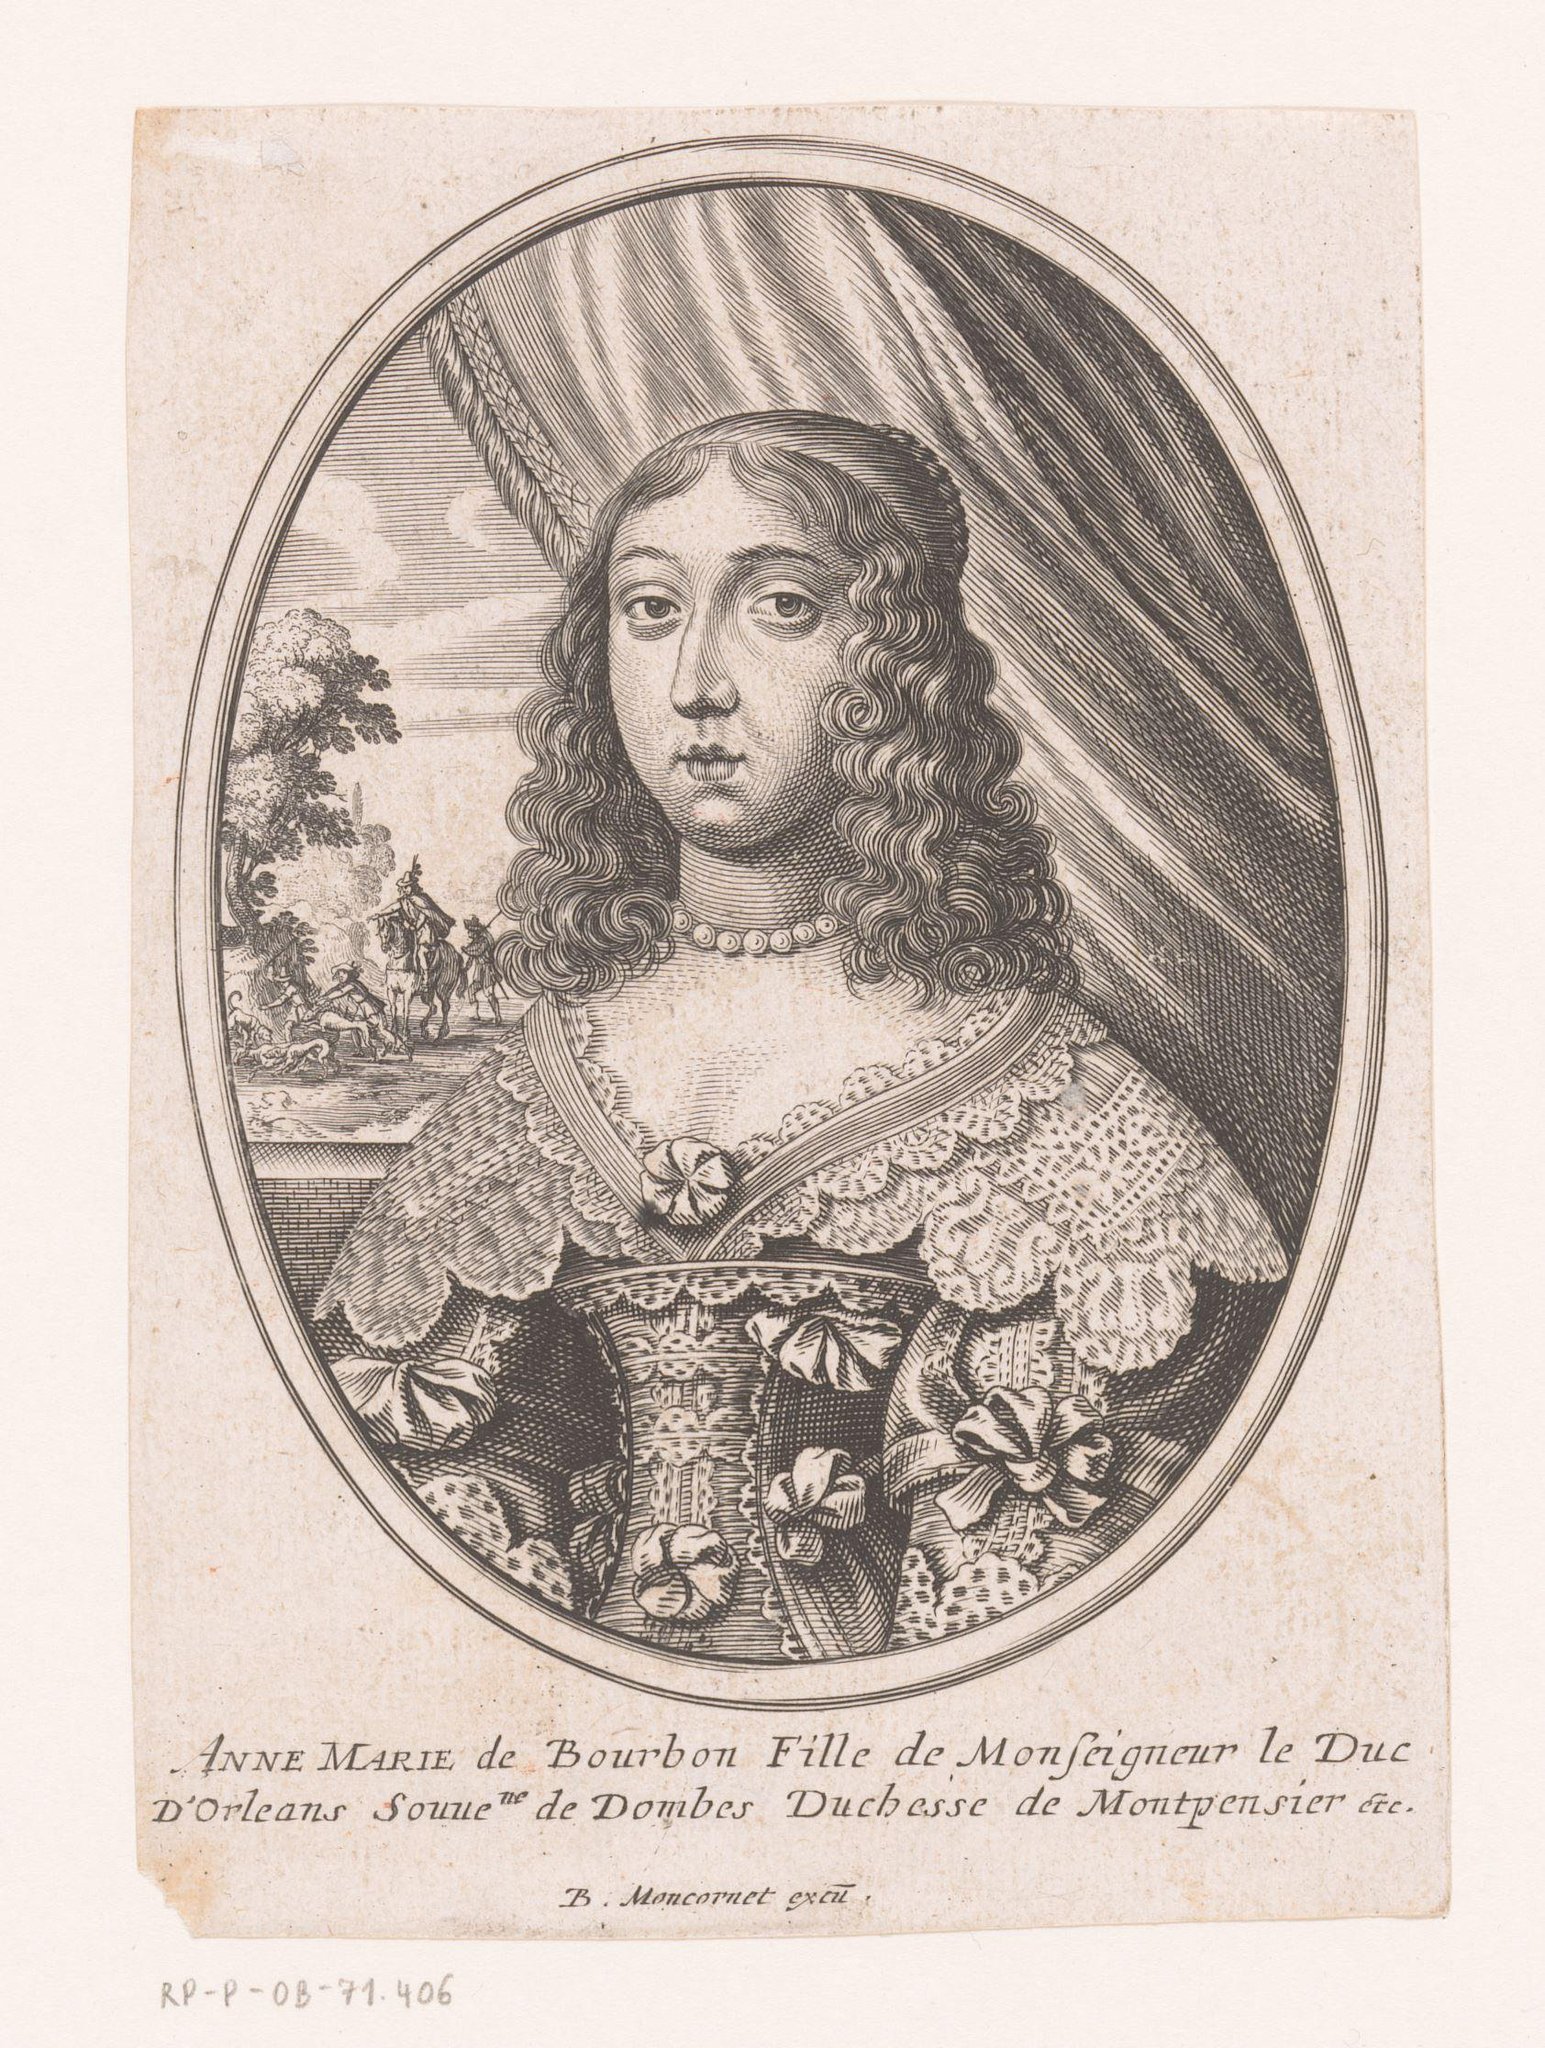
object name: print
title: Portret van Anne Marie Louise van Orléans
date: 1637-1668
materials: paper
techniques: engraving, etching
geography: paris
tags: paris, anne marie louise d' orléans (hertogin van montpensier), historical persons - bb - woman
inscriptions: collector's mark: Lugt 240